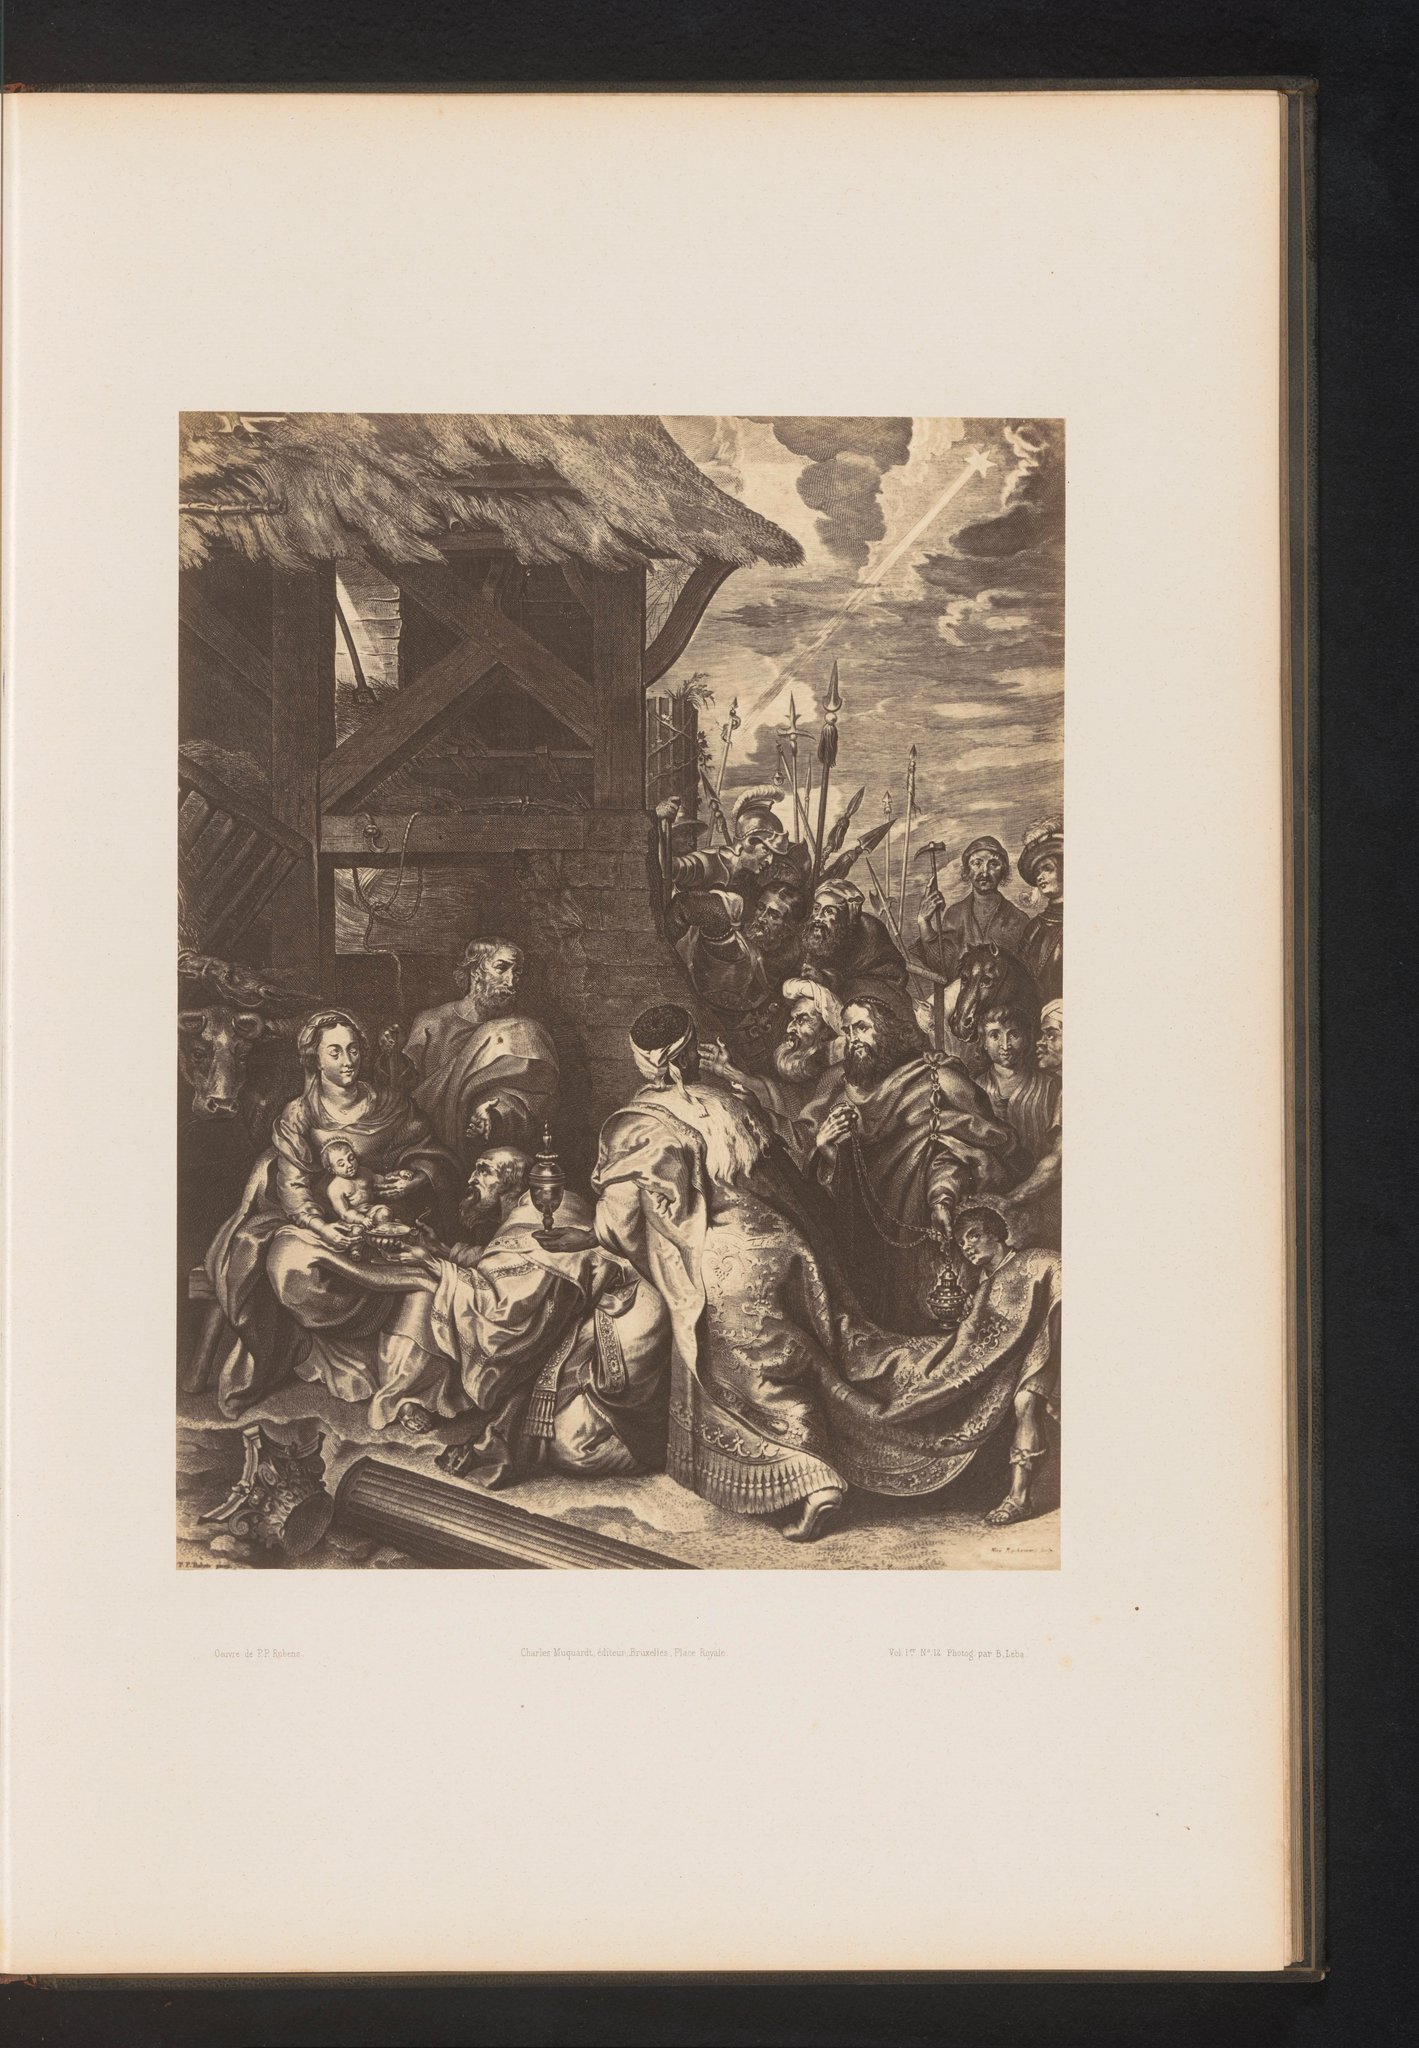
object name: photograph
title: Fotoreproductie van een gravure van de Aanbidding door de koningen door Nicolaes Ryckmans, naar het schilderij door Peter Paul Rubens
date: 1853-1858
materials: photographic support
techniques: albumen print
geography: brussels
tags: adoration of the kings: the wise men present their gifts to the christ-child (gold, frankincense and myrrh)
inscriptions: number: ‘Vol. 1er. No 12.’